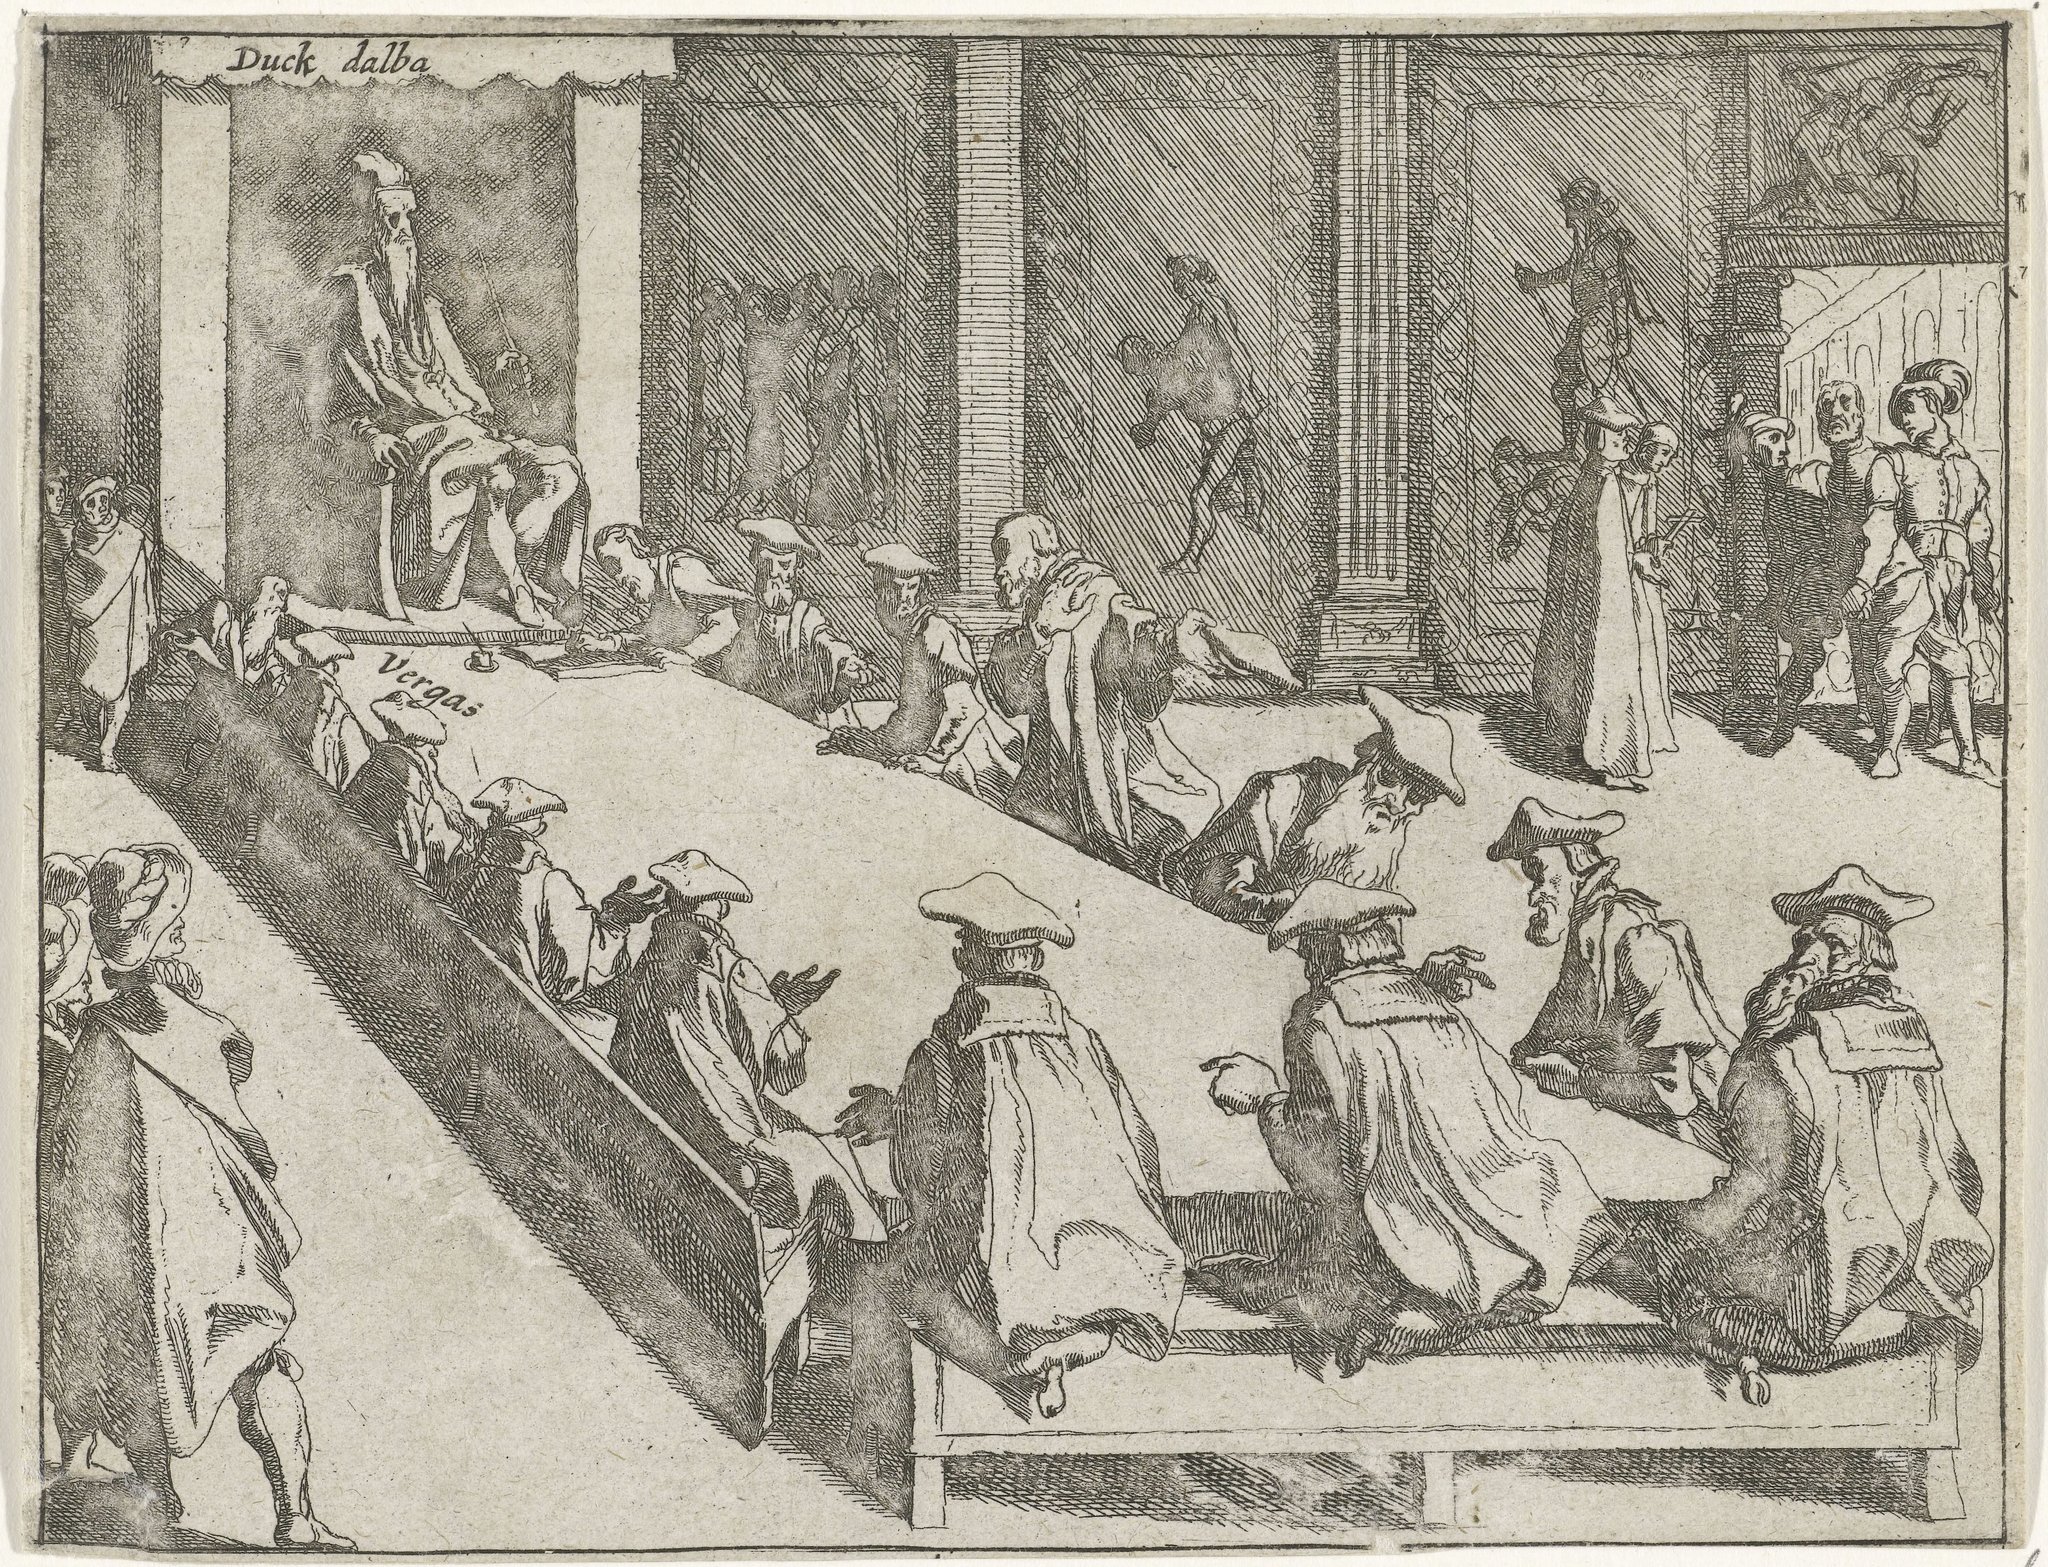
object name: print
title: Zitting van de Spaanse Bloedraad, 1567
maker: simon frisius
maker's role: print maker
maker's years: 1570-1628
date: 1613-1615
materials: paper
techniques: etching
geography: northern netherlands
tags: fernando álvarez de toledo (3rd duke of alba), court session (court of justice)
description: Zitting van de Raad van Beroerten, bijgenaamd de Bloedraad, voorgezeten door de hertog van Alva gezeten op een troon met de gerechtsroede in de hand, 1567. Aan de muren van het interieur hangen wandkleden. Achterzijde onbedrukt.